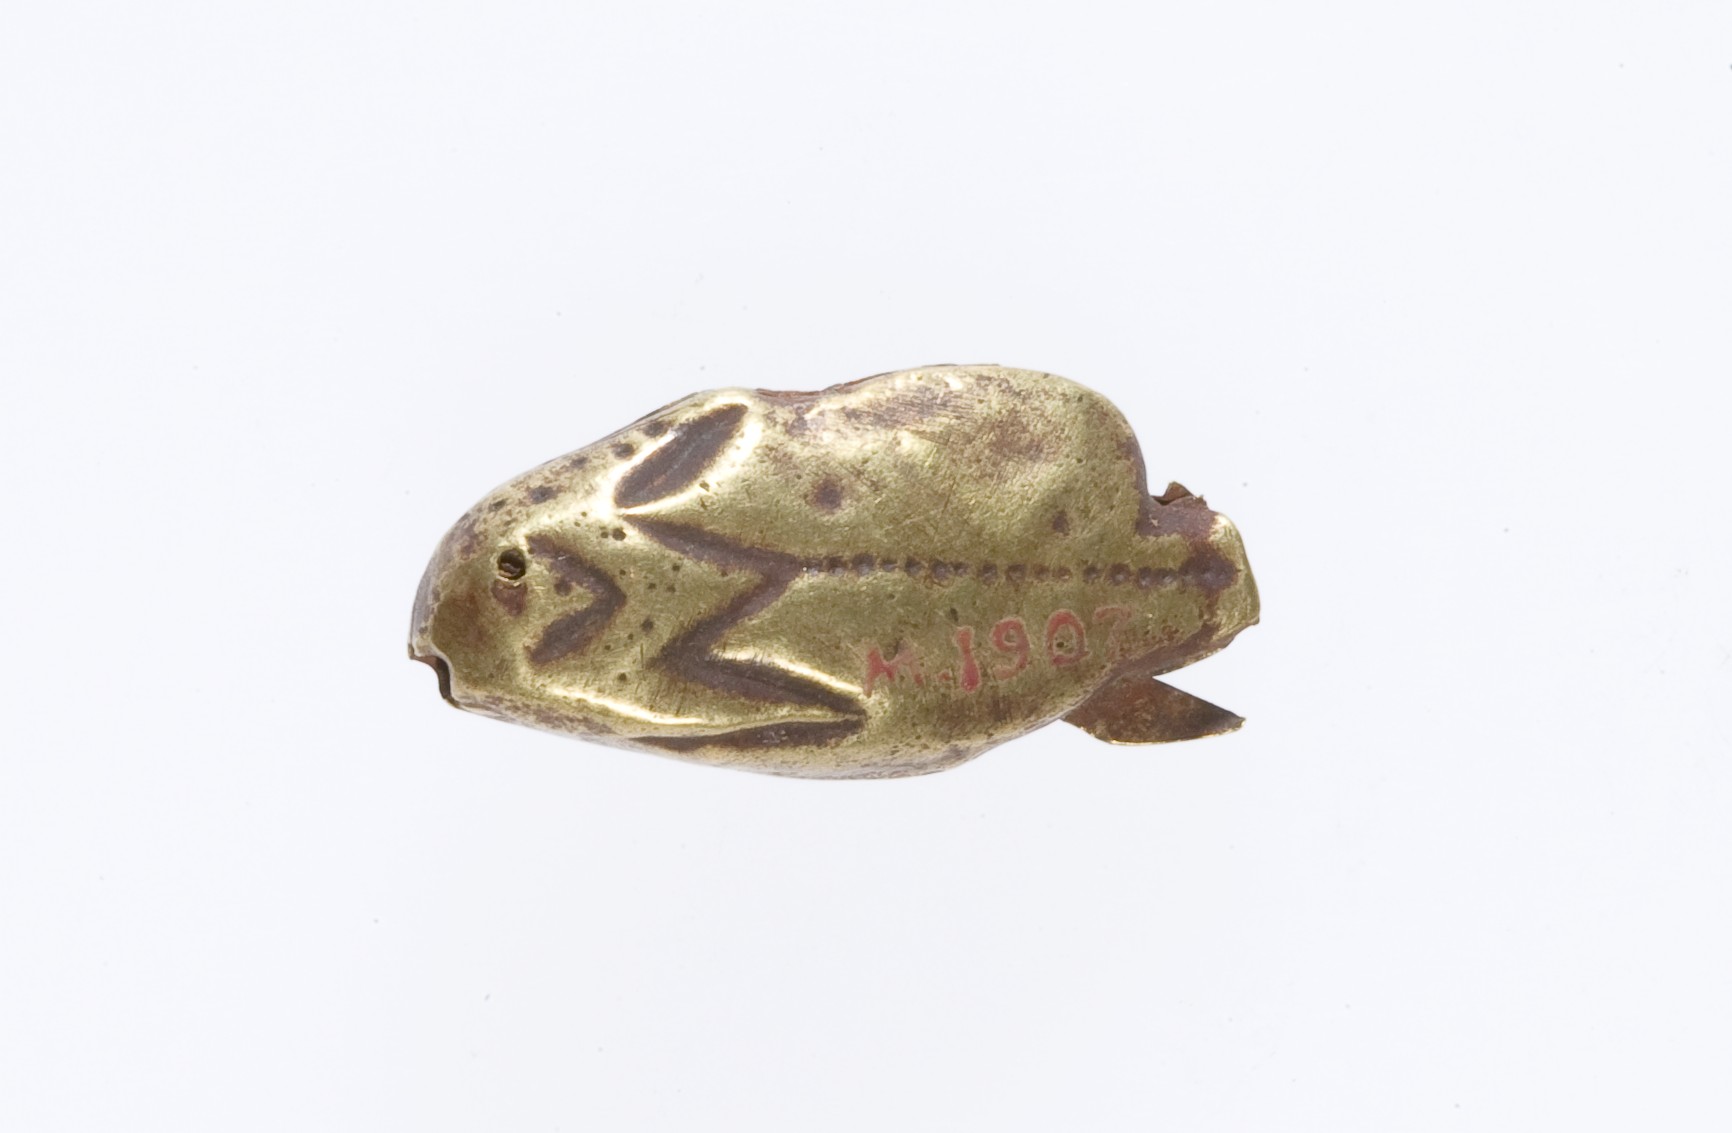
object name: amulet, fish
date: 1981-1550 BCE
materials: gold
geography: egypt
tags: fish